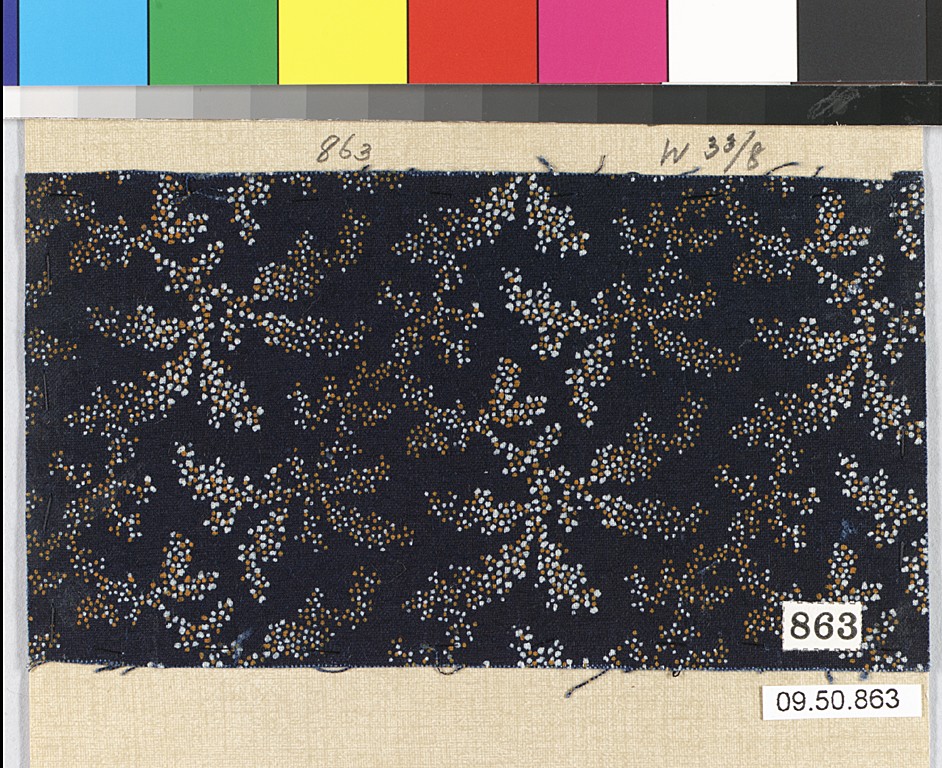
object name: piece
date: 1801-1900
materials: cotton